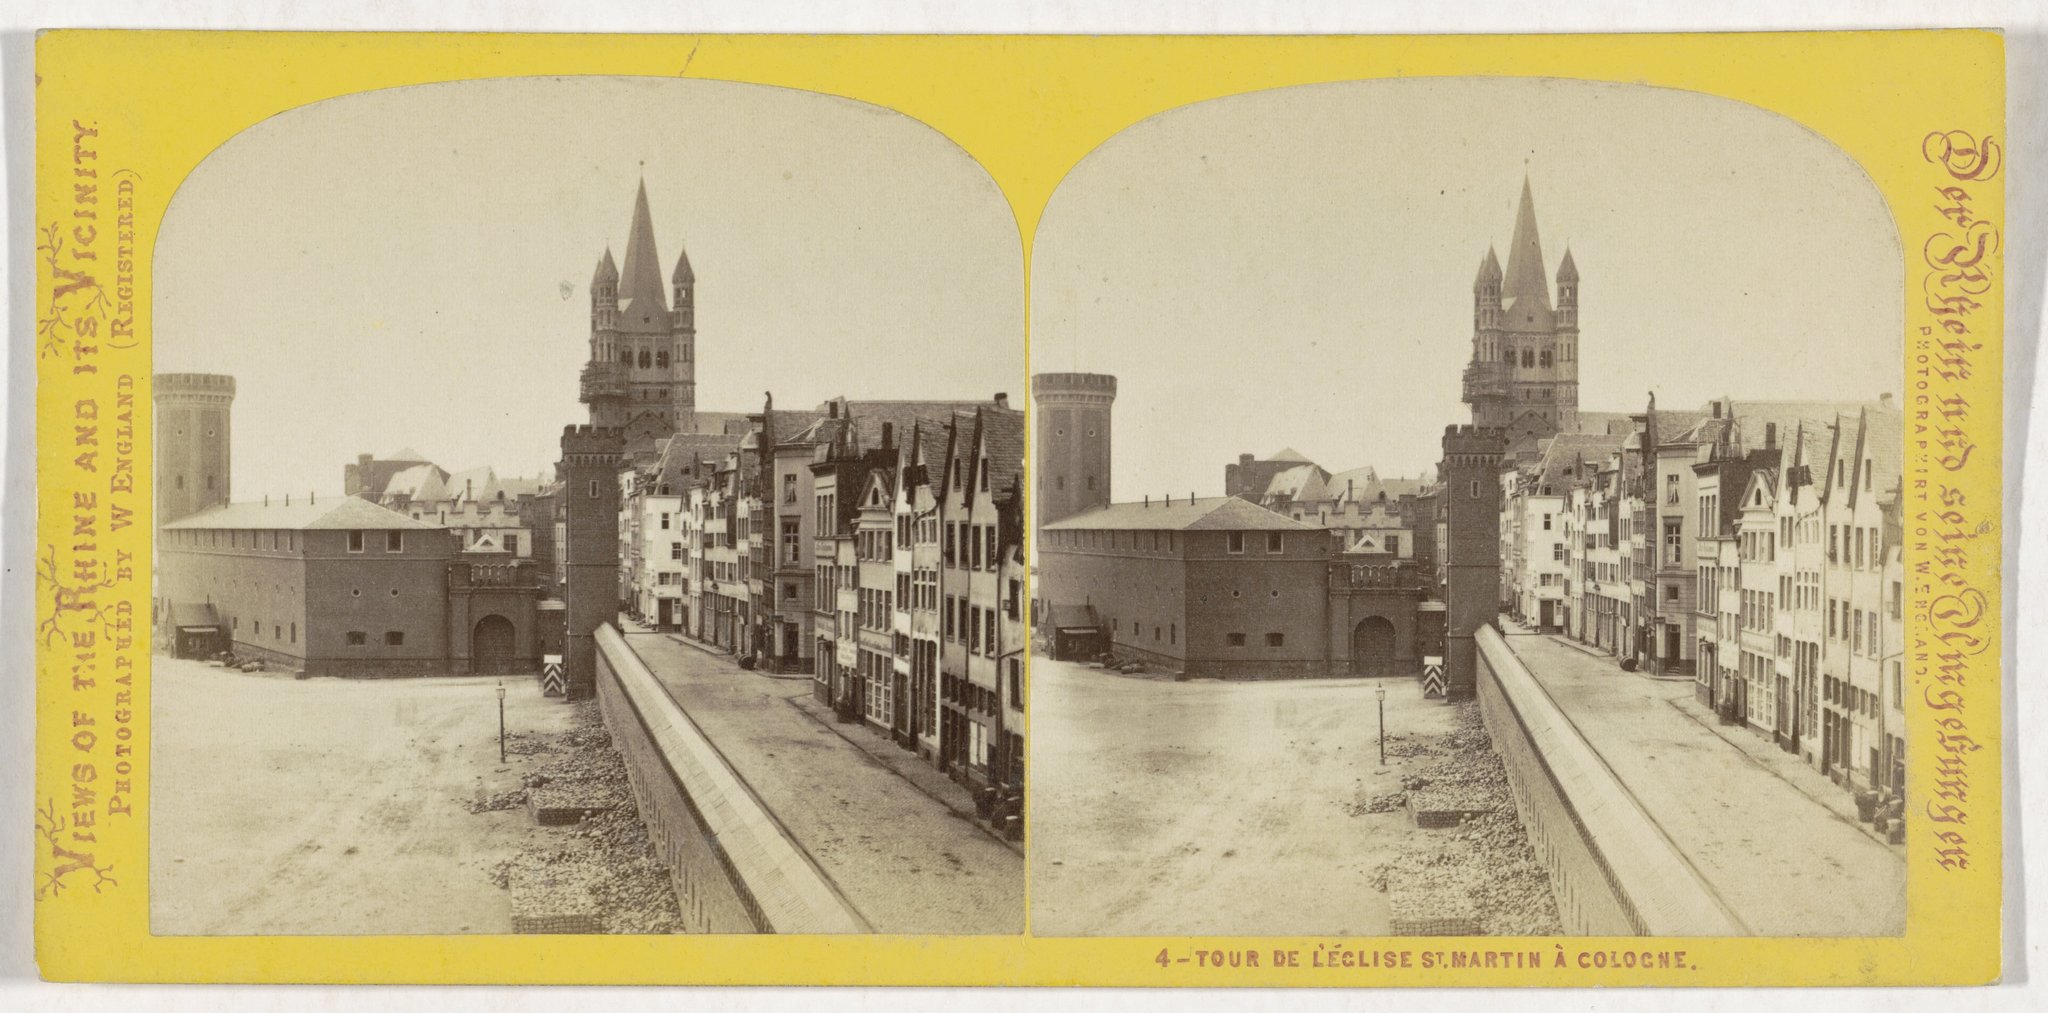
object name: stereograph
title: Views of the Rhine and its Vicinity / Der Rhein und seine Umgebungen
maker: william england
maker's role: fotograaf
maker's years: 1816-1896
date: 1867-1868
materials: cardboard, paper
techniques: albumen print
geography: cologne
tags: walls ~ fortified city, parts of church exterior and annexes: tower, cologne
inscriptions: number: ‘4’, inscription: ‘(Registered)’